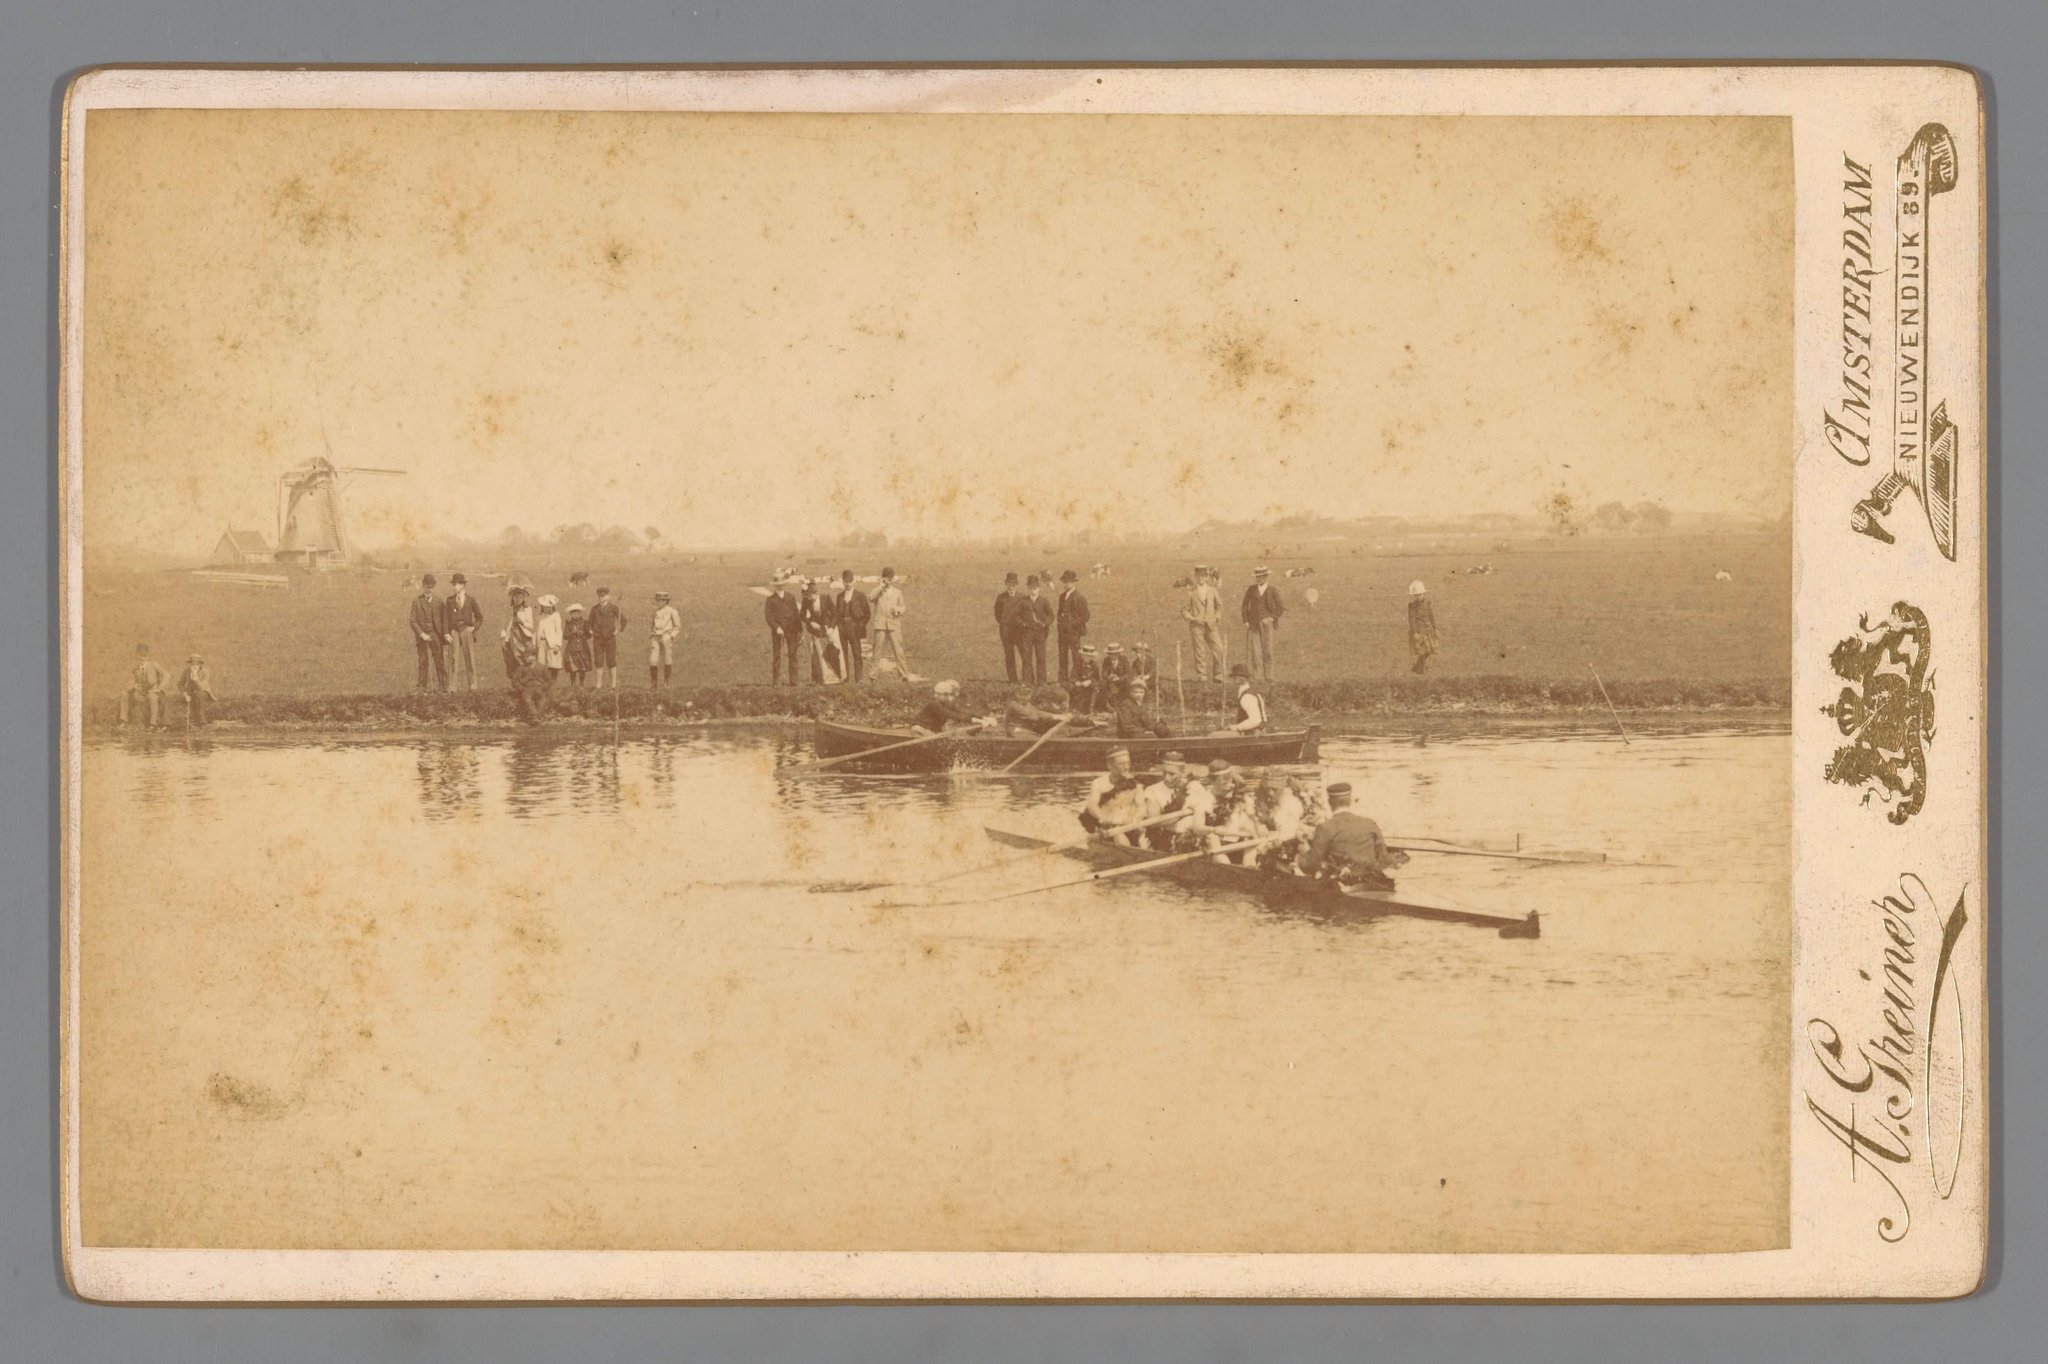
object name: cabinet photograph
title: De ploeg van Nereus nadat zij de universiteitsroeiwedstrijden op het Spaarne in Haarlem gewonnen hebben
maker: albert greiner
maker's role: fotograaf, fotostudio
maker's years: 1833-1890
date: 1874-1887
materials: cardboard, photographic support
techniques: albumen print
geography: amsterdam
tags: rowing facing backward, pulling (+ four persons or more ~ traffic and transport), canal, amsterdam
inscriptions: address: ‘Amsterdam/ NIEUWENDIJK 89.’, inscription: ‘Kön. Ned. Hof-Photograaf/ Albert Greiner/ Amsterdam/ Nieuwendijk 89./ Specialiteit/ in Vergrootingen.’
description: De ploeg van het Amsterdamse Nereus nadat zij de universiteitsroeiwedstrijden (Varsity) op het Spaarne in Haarlem gewonnen hebben.